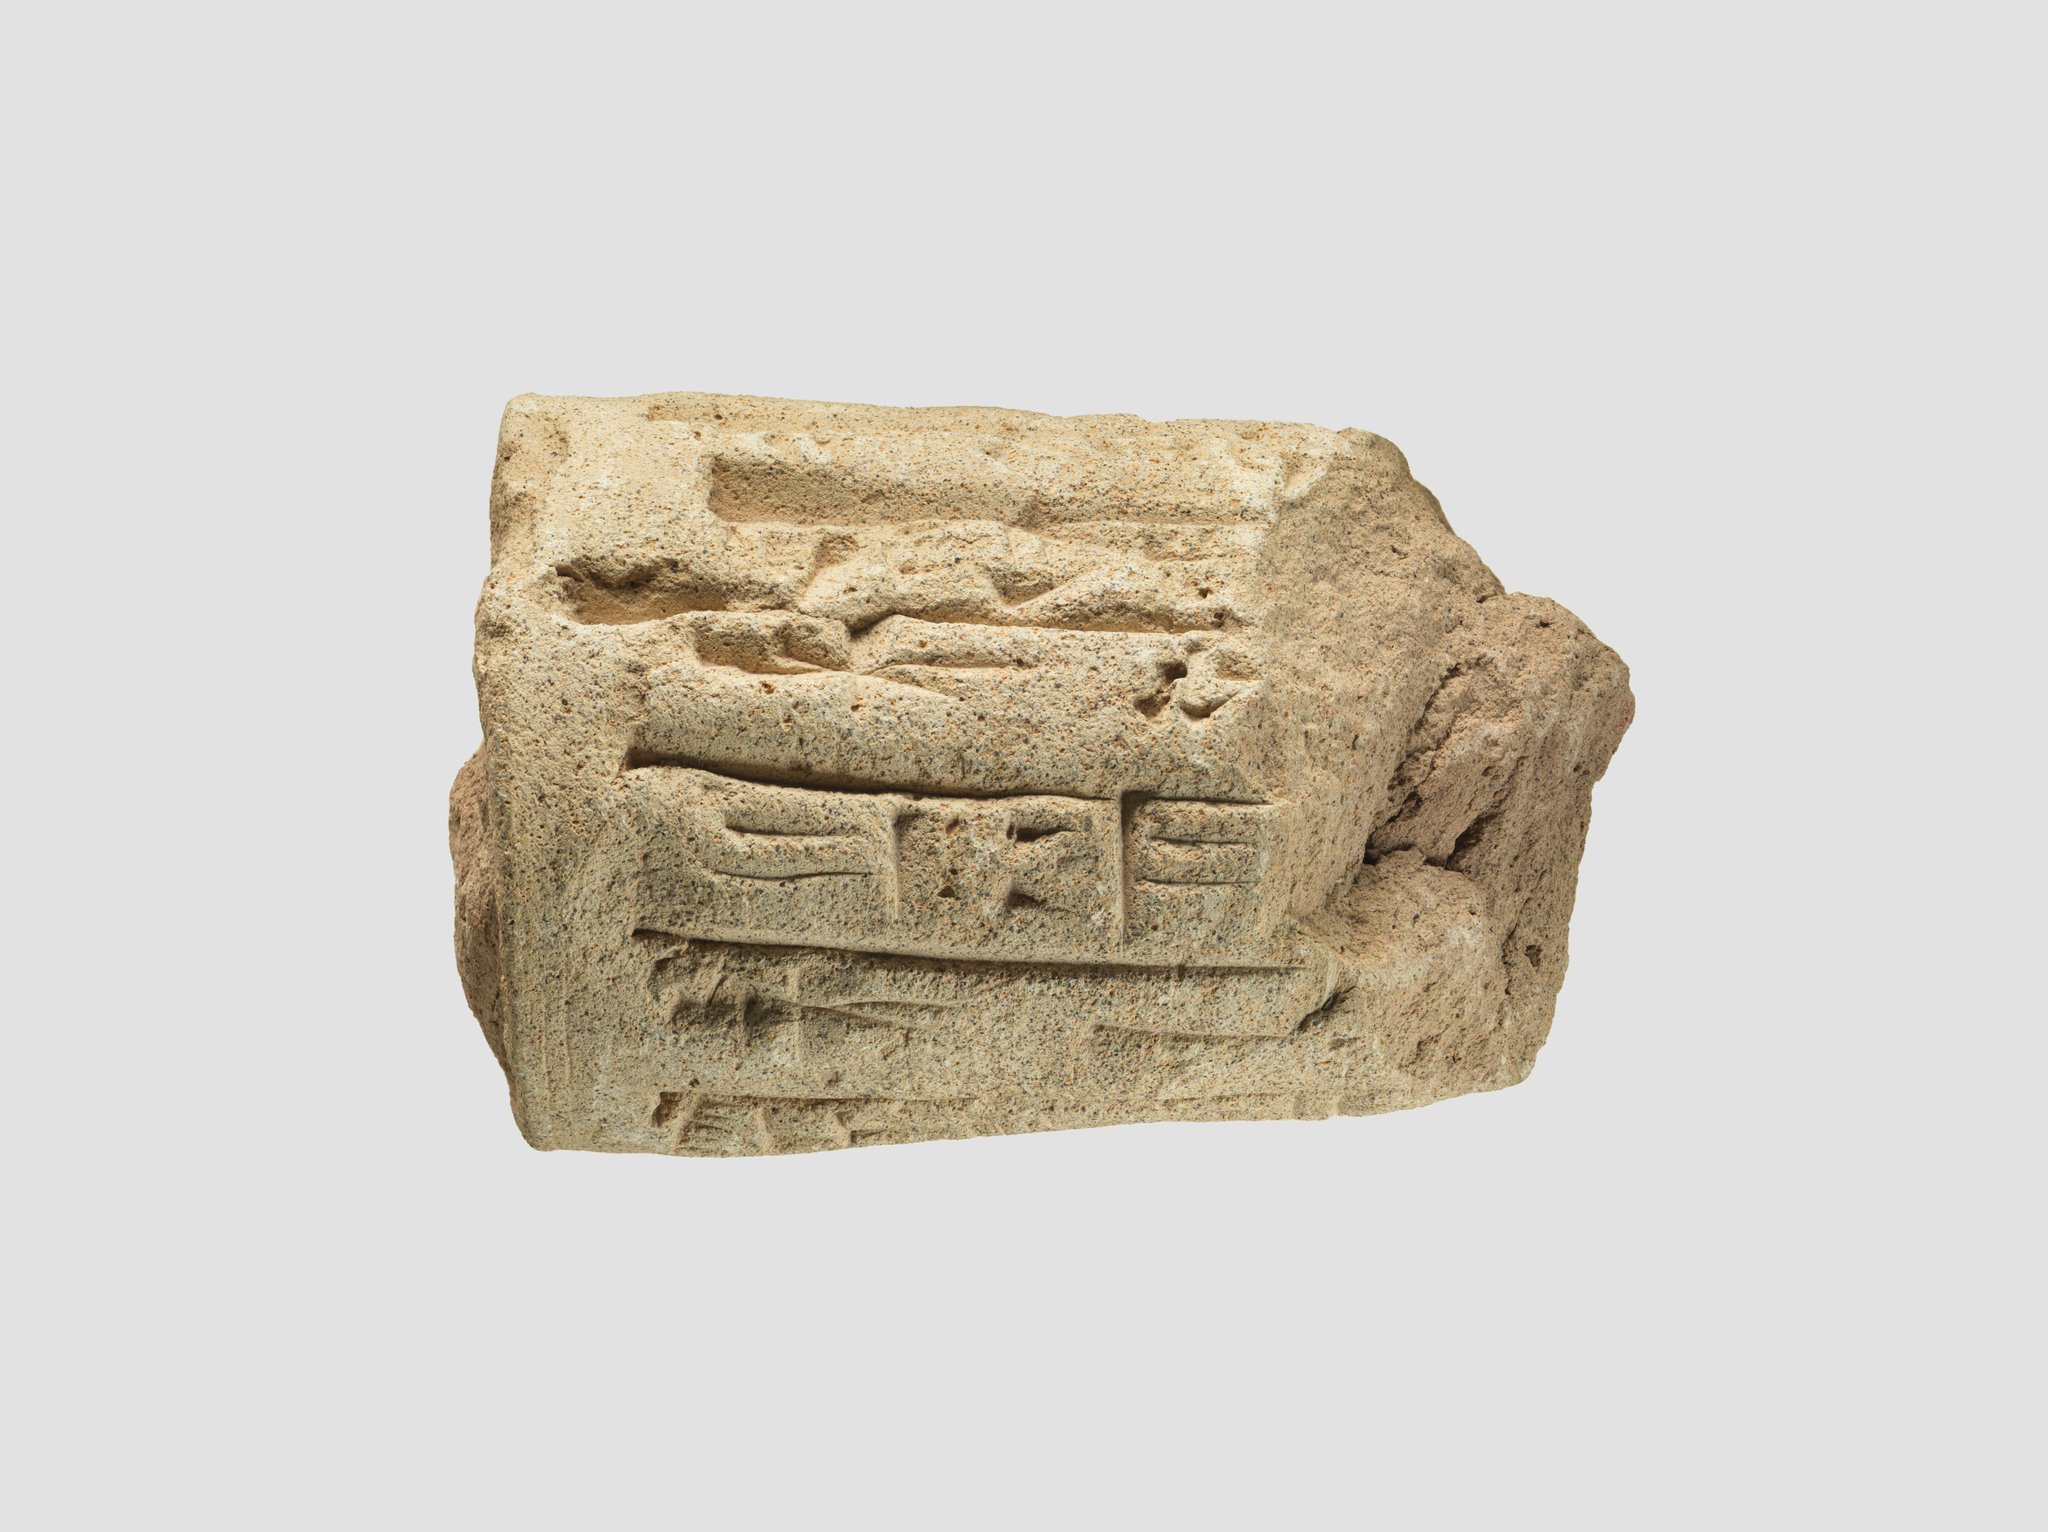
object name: cuneiform cone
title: Votive cone with cuneiform inscription of Gudea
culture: neo-sumerian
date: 2090 BCE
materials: clay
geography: mesopotamia